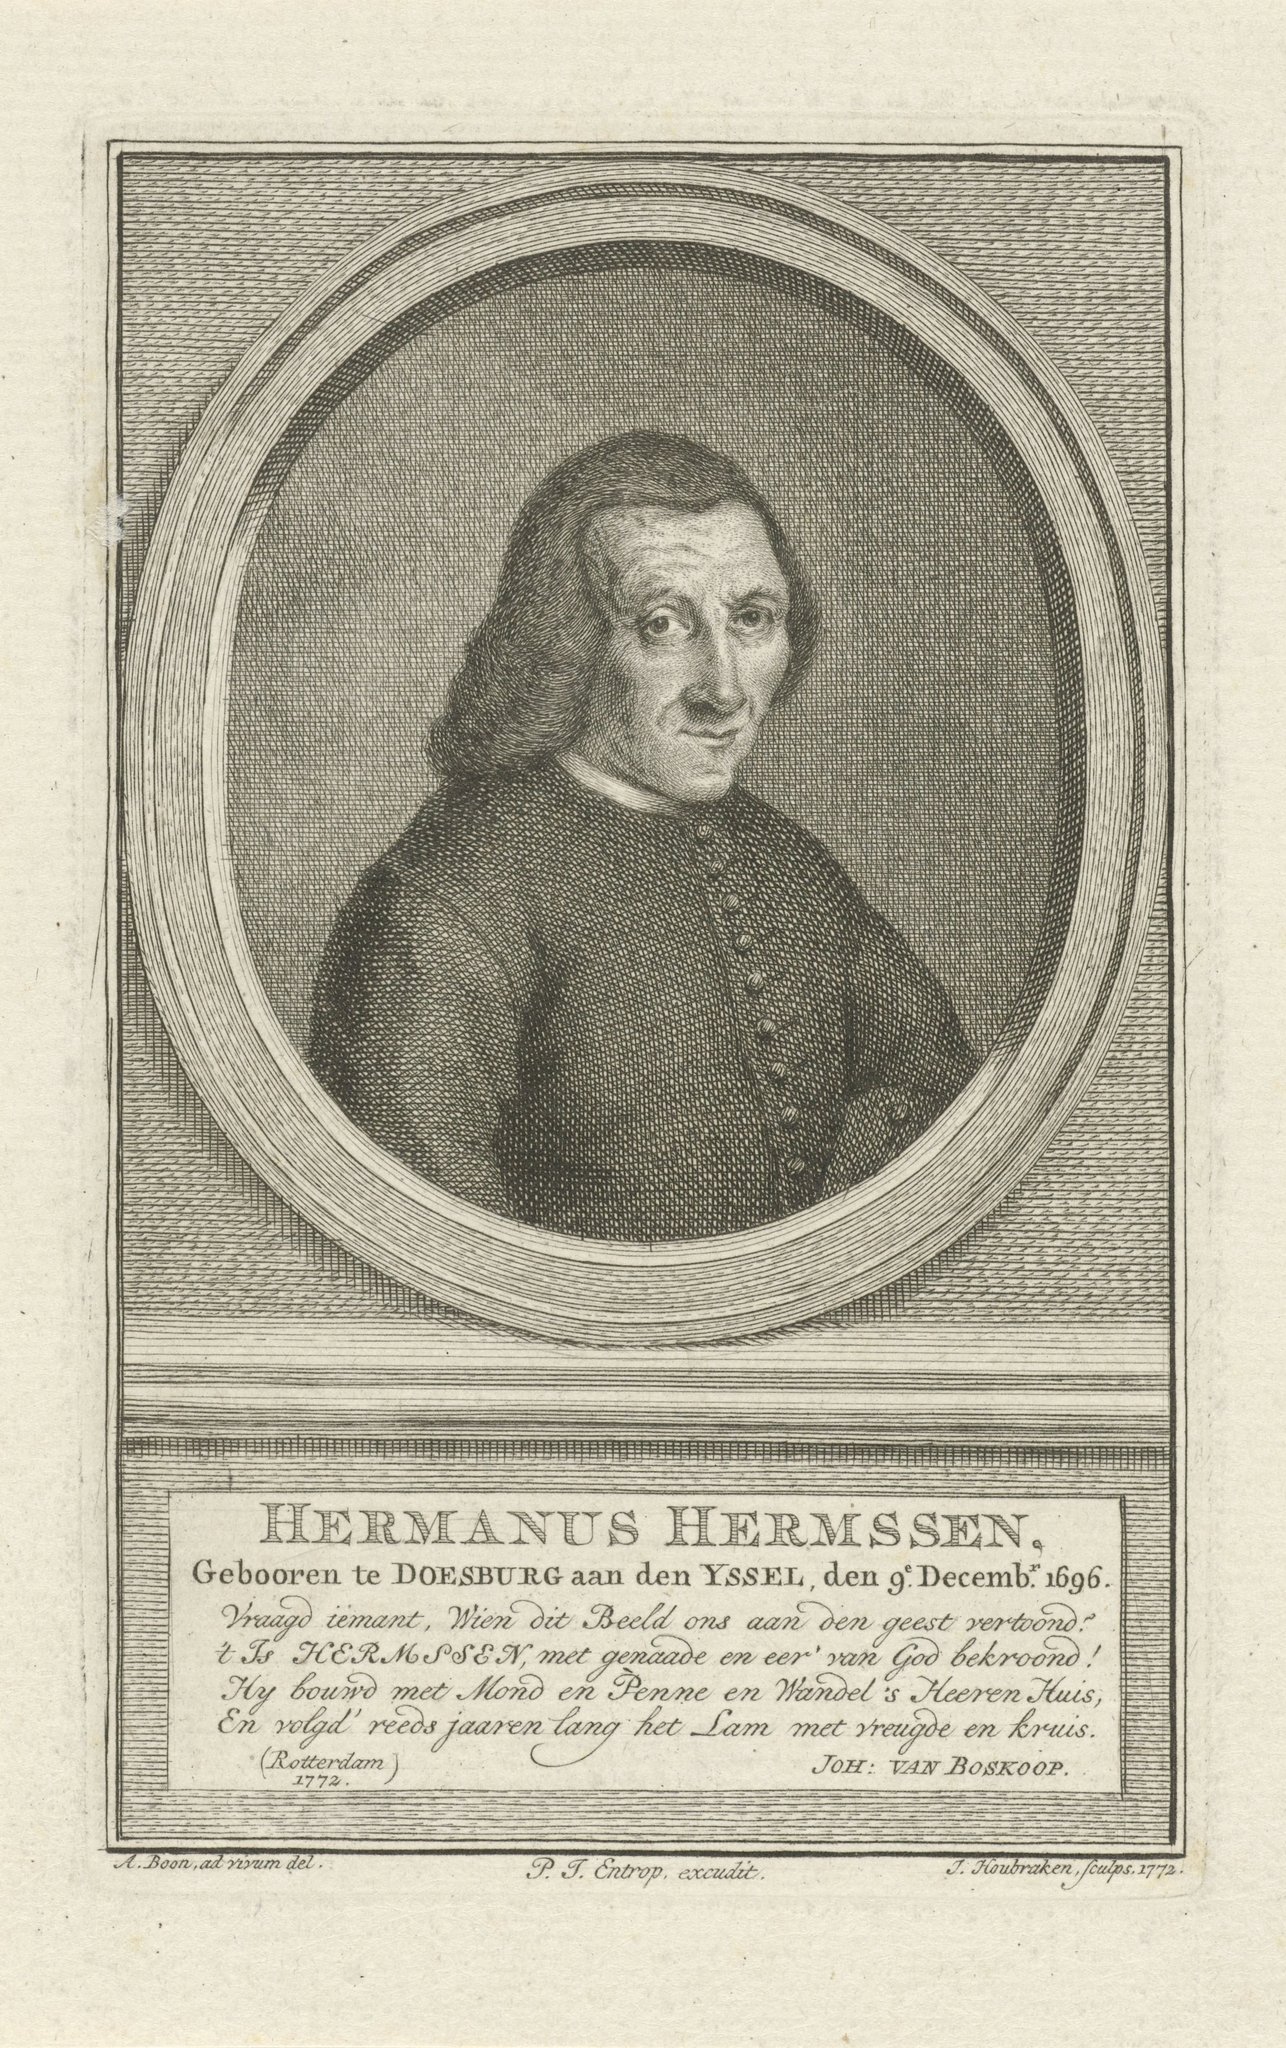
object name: print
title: Hermanus Hermssen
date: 1772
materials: paper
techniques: engraving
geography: amsterdam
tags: doesburg, hermanus hermsen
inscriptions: collector's mark: Lugt 2228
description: Buste naar rechts van Hermanus Hermsen in een ovaal. Het portret rust op een plint waarop zijn naam en gegevens in twee regels in het Nederlands en daaronder een vierregelig vers in het Nederlands.